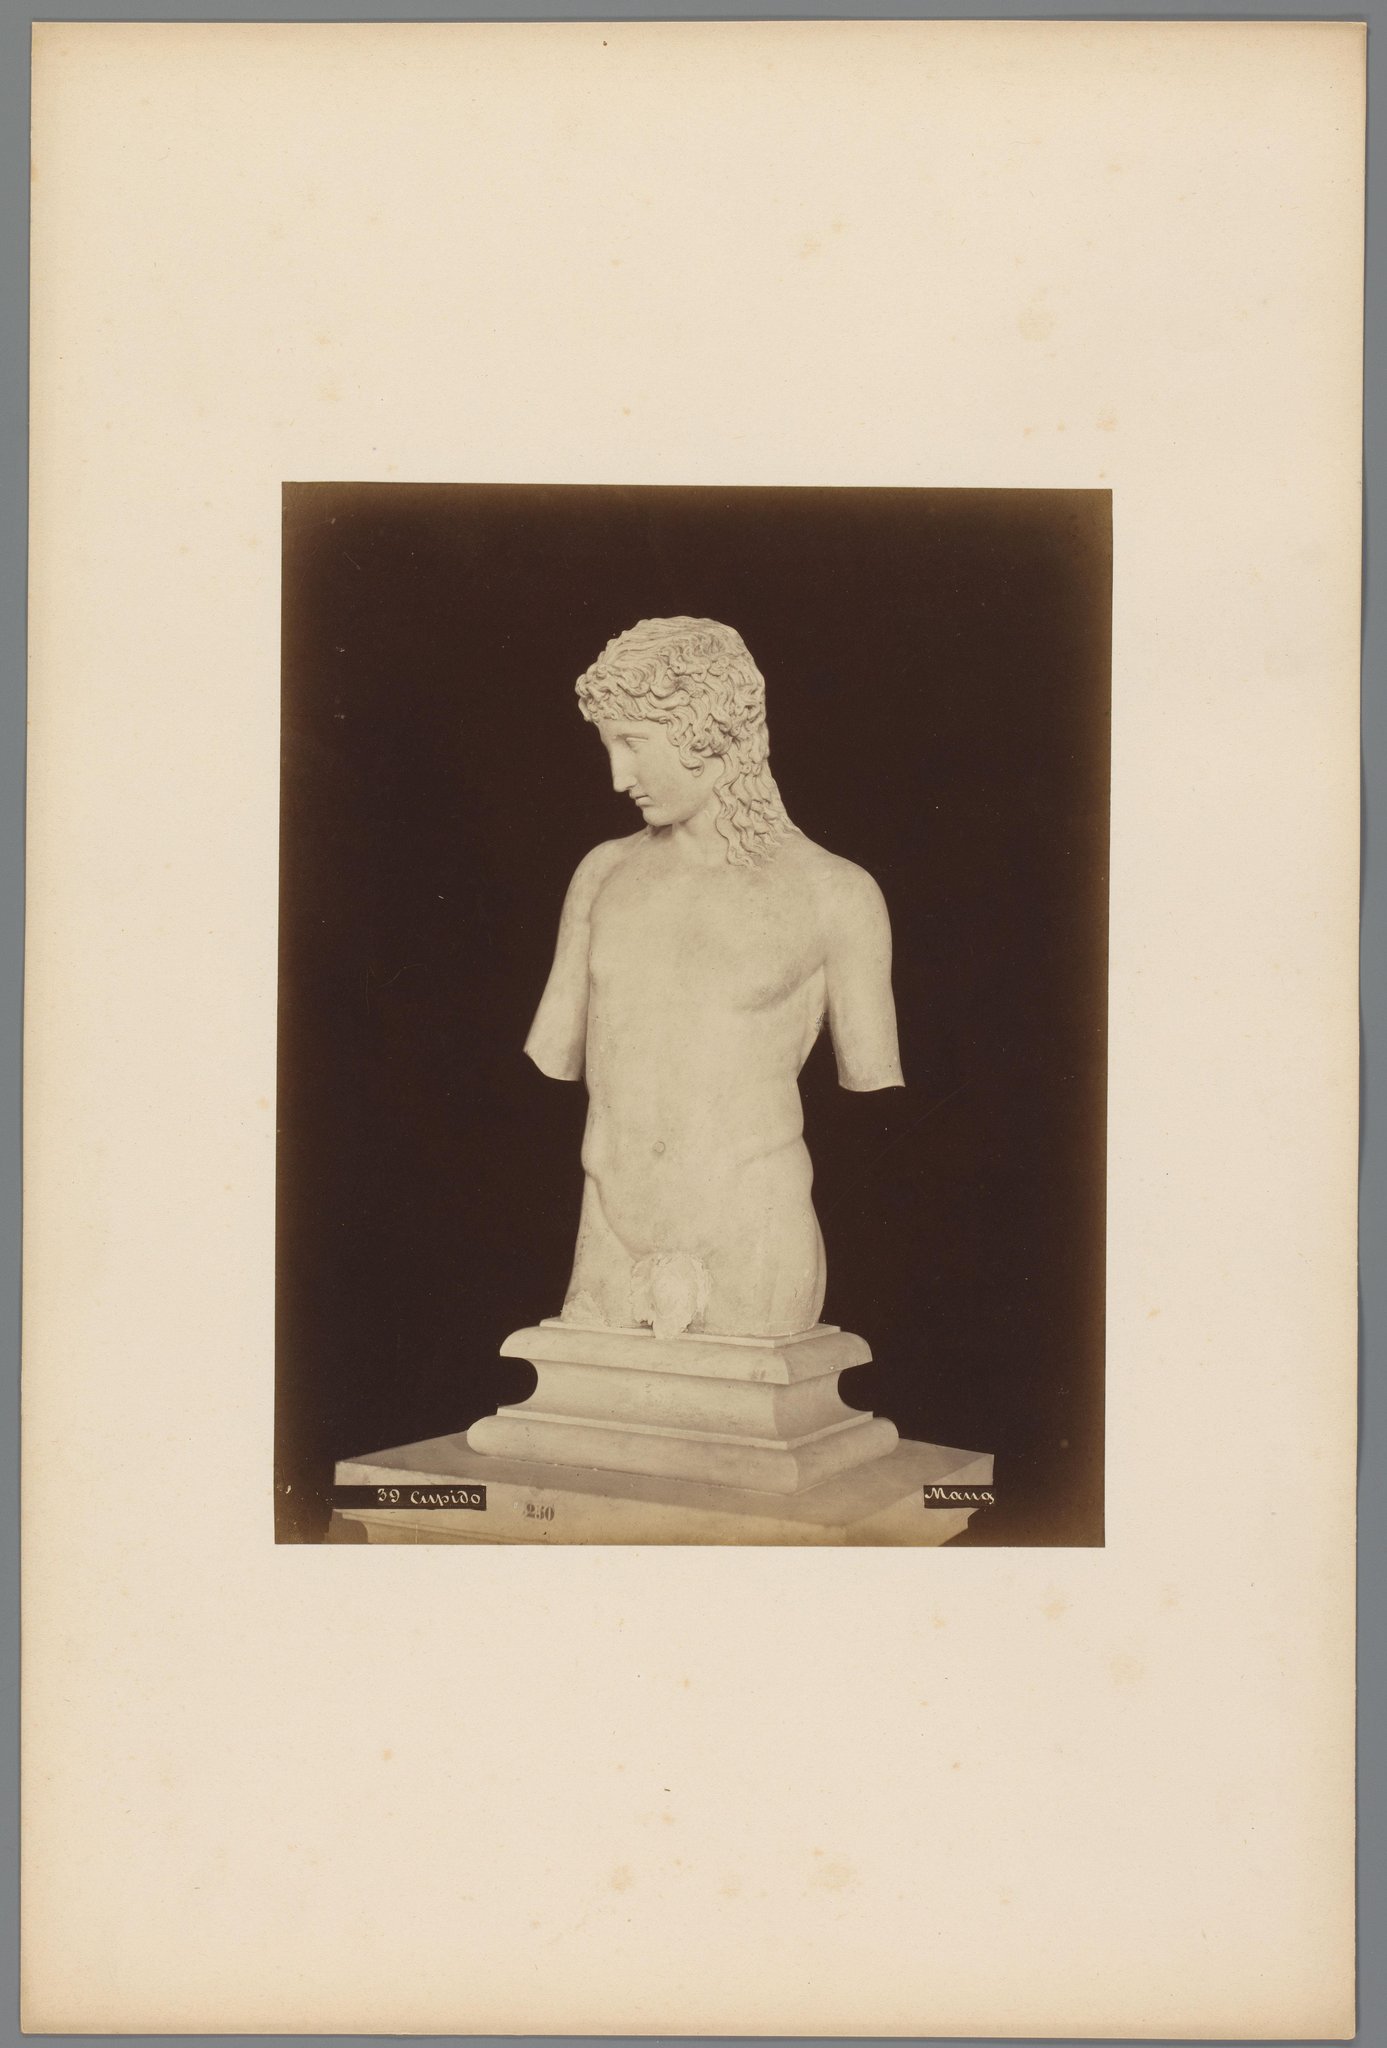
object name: photograph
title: Cupido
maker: michèle mang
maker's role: fotograaf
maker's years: 1840-1909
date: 1863-1887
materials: cardboard, paper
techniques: albumen print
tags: piece of sculpture, reproduction of a piece of sculpture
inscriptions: number: ‘39’